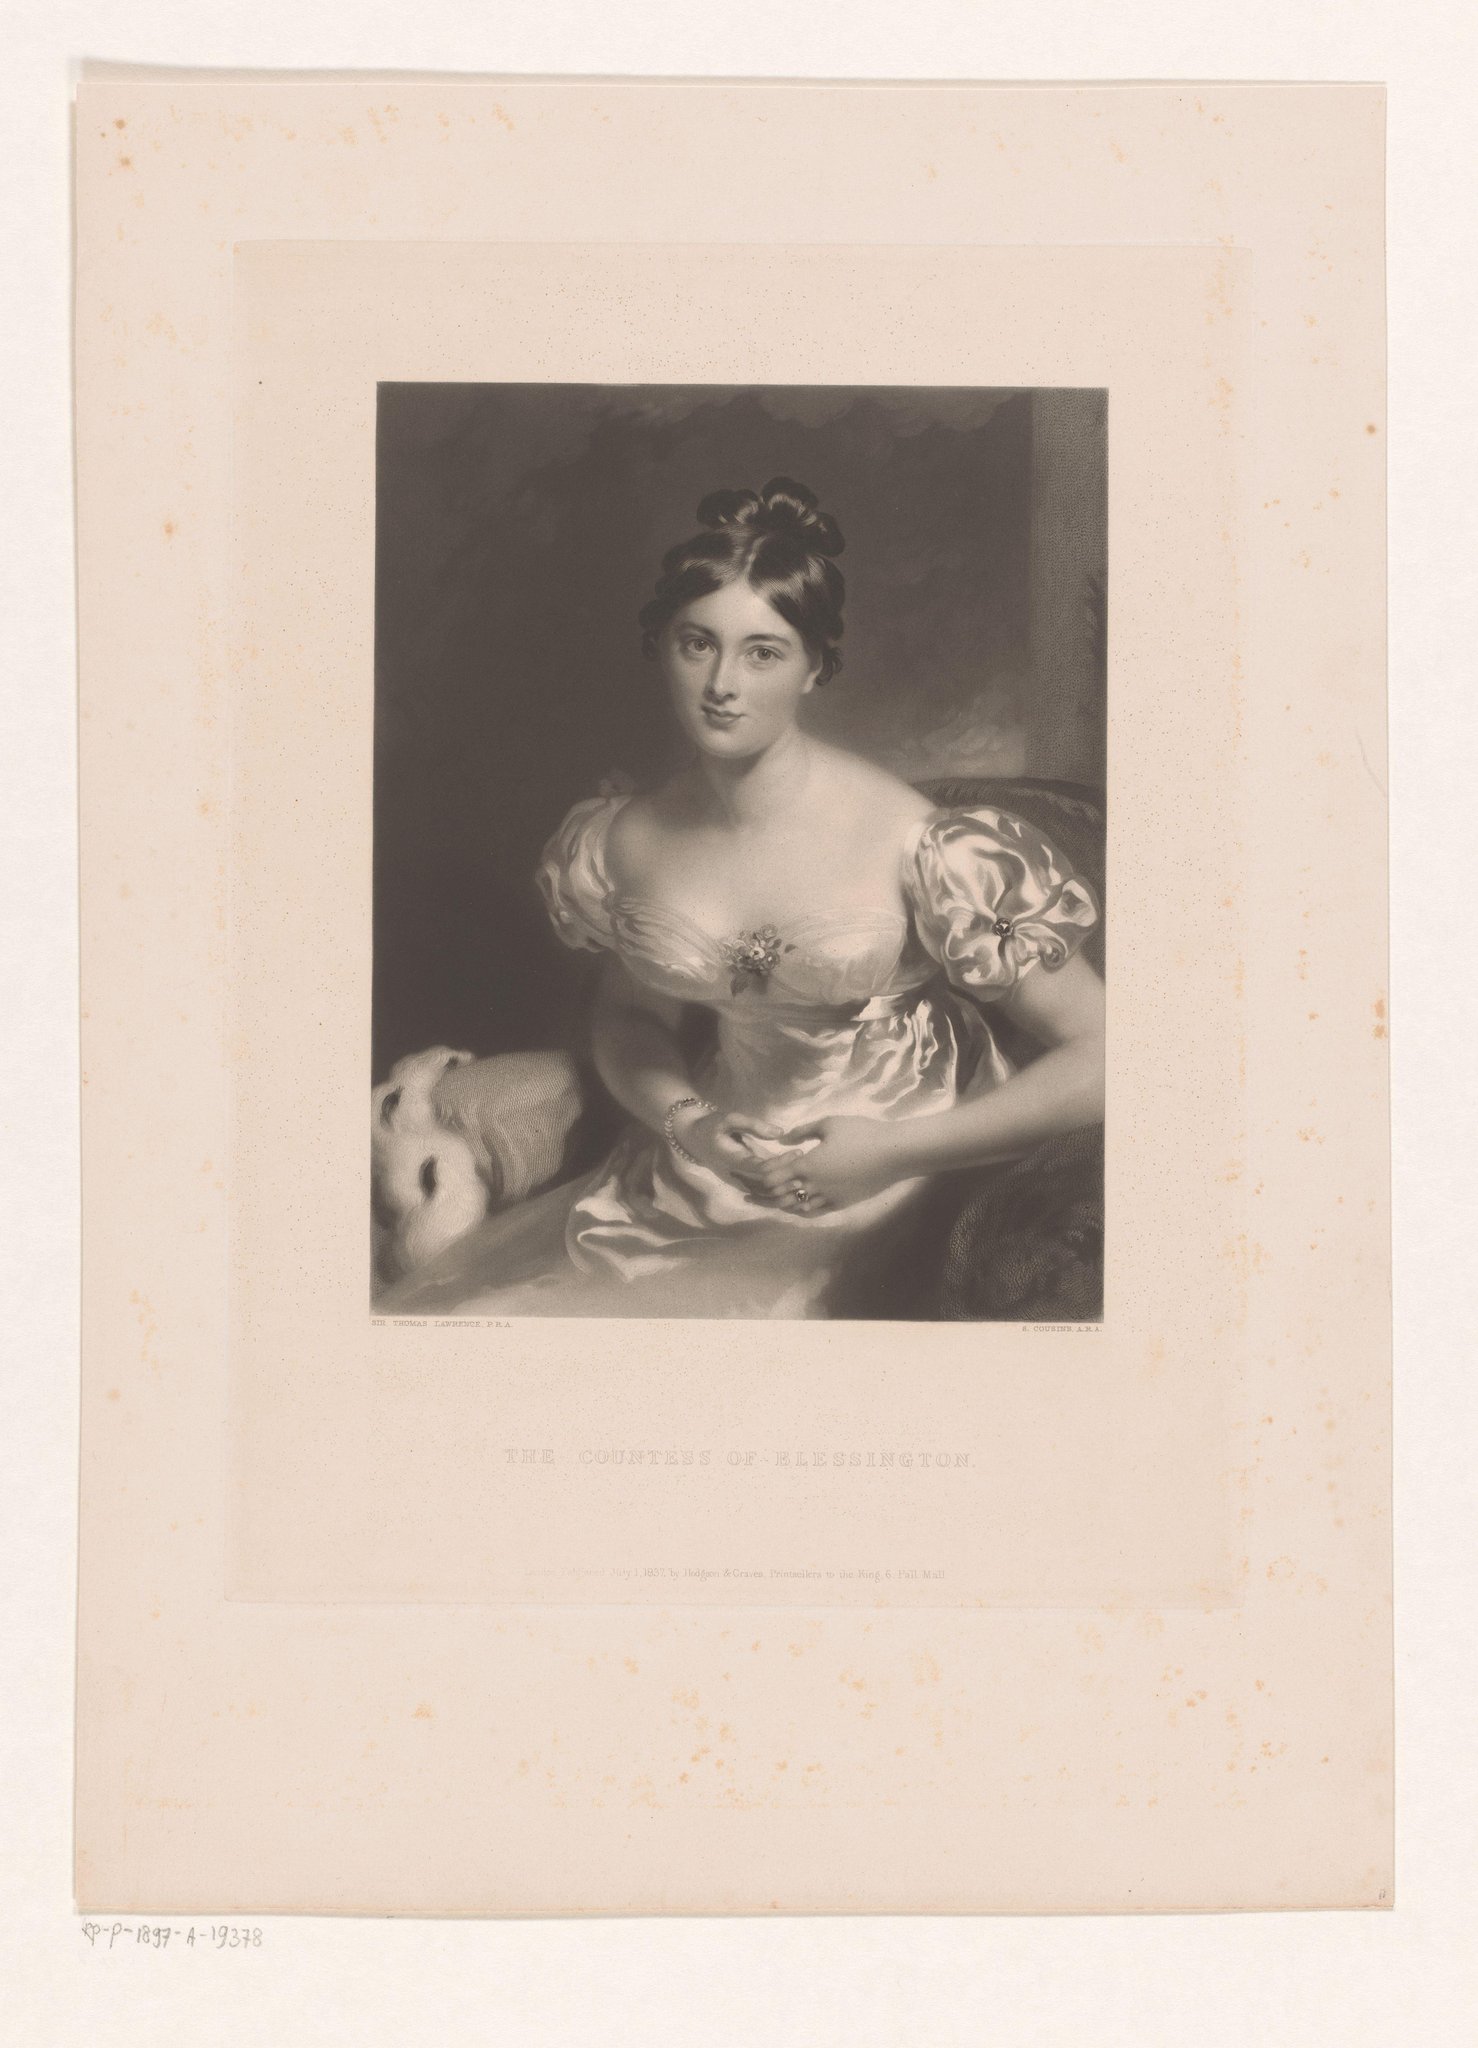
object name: print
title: Portret van Marguerite Gardiner, hertogin van Blessington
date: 1837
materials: paper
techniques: etching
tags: historical persons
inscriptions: collector's mark: Lugt 2228